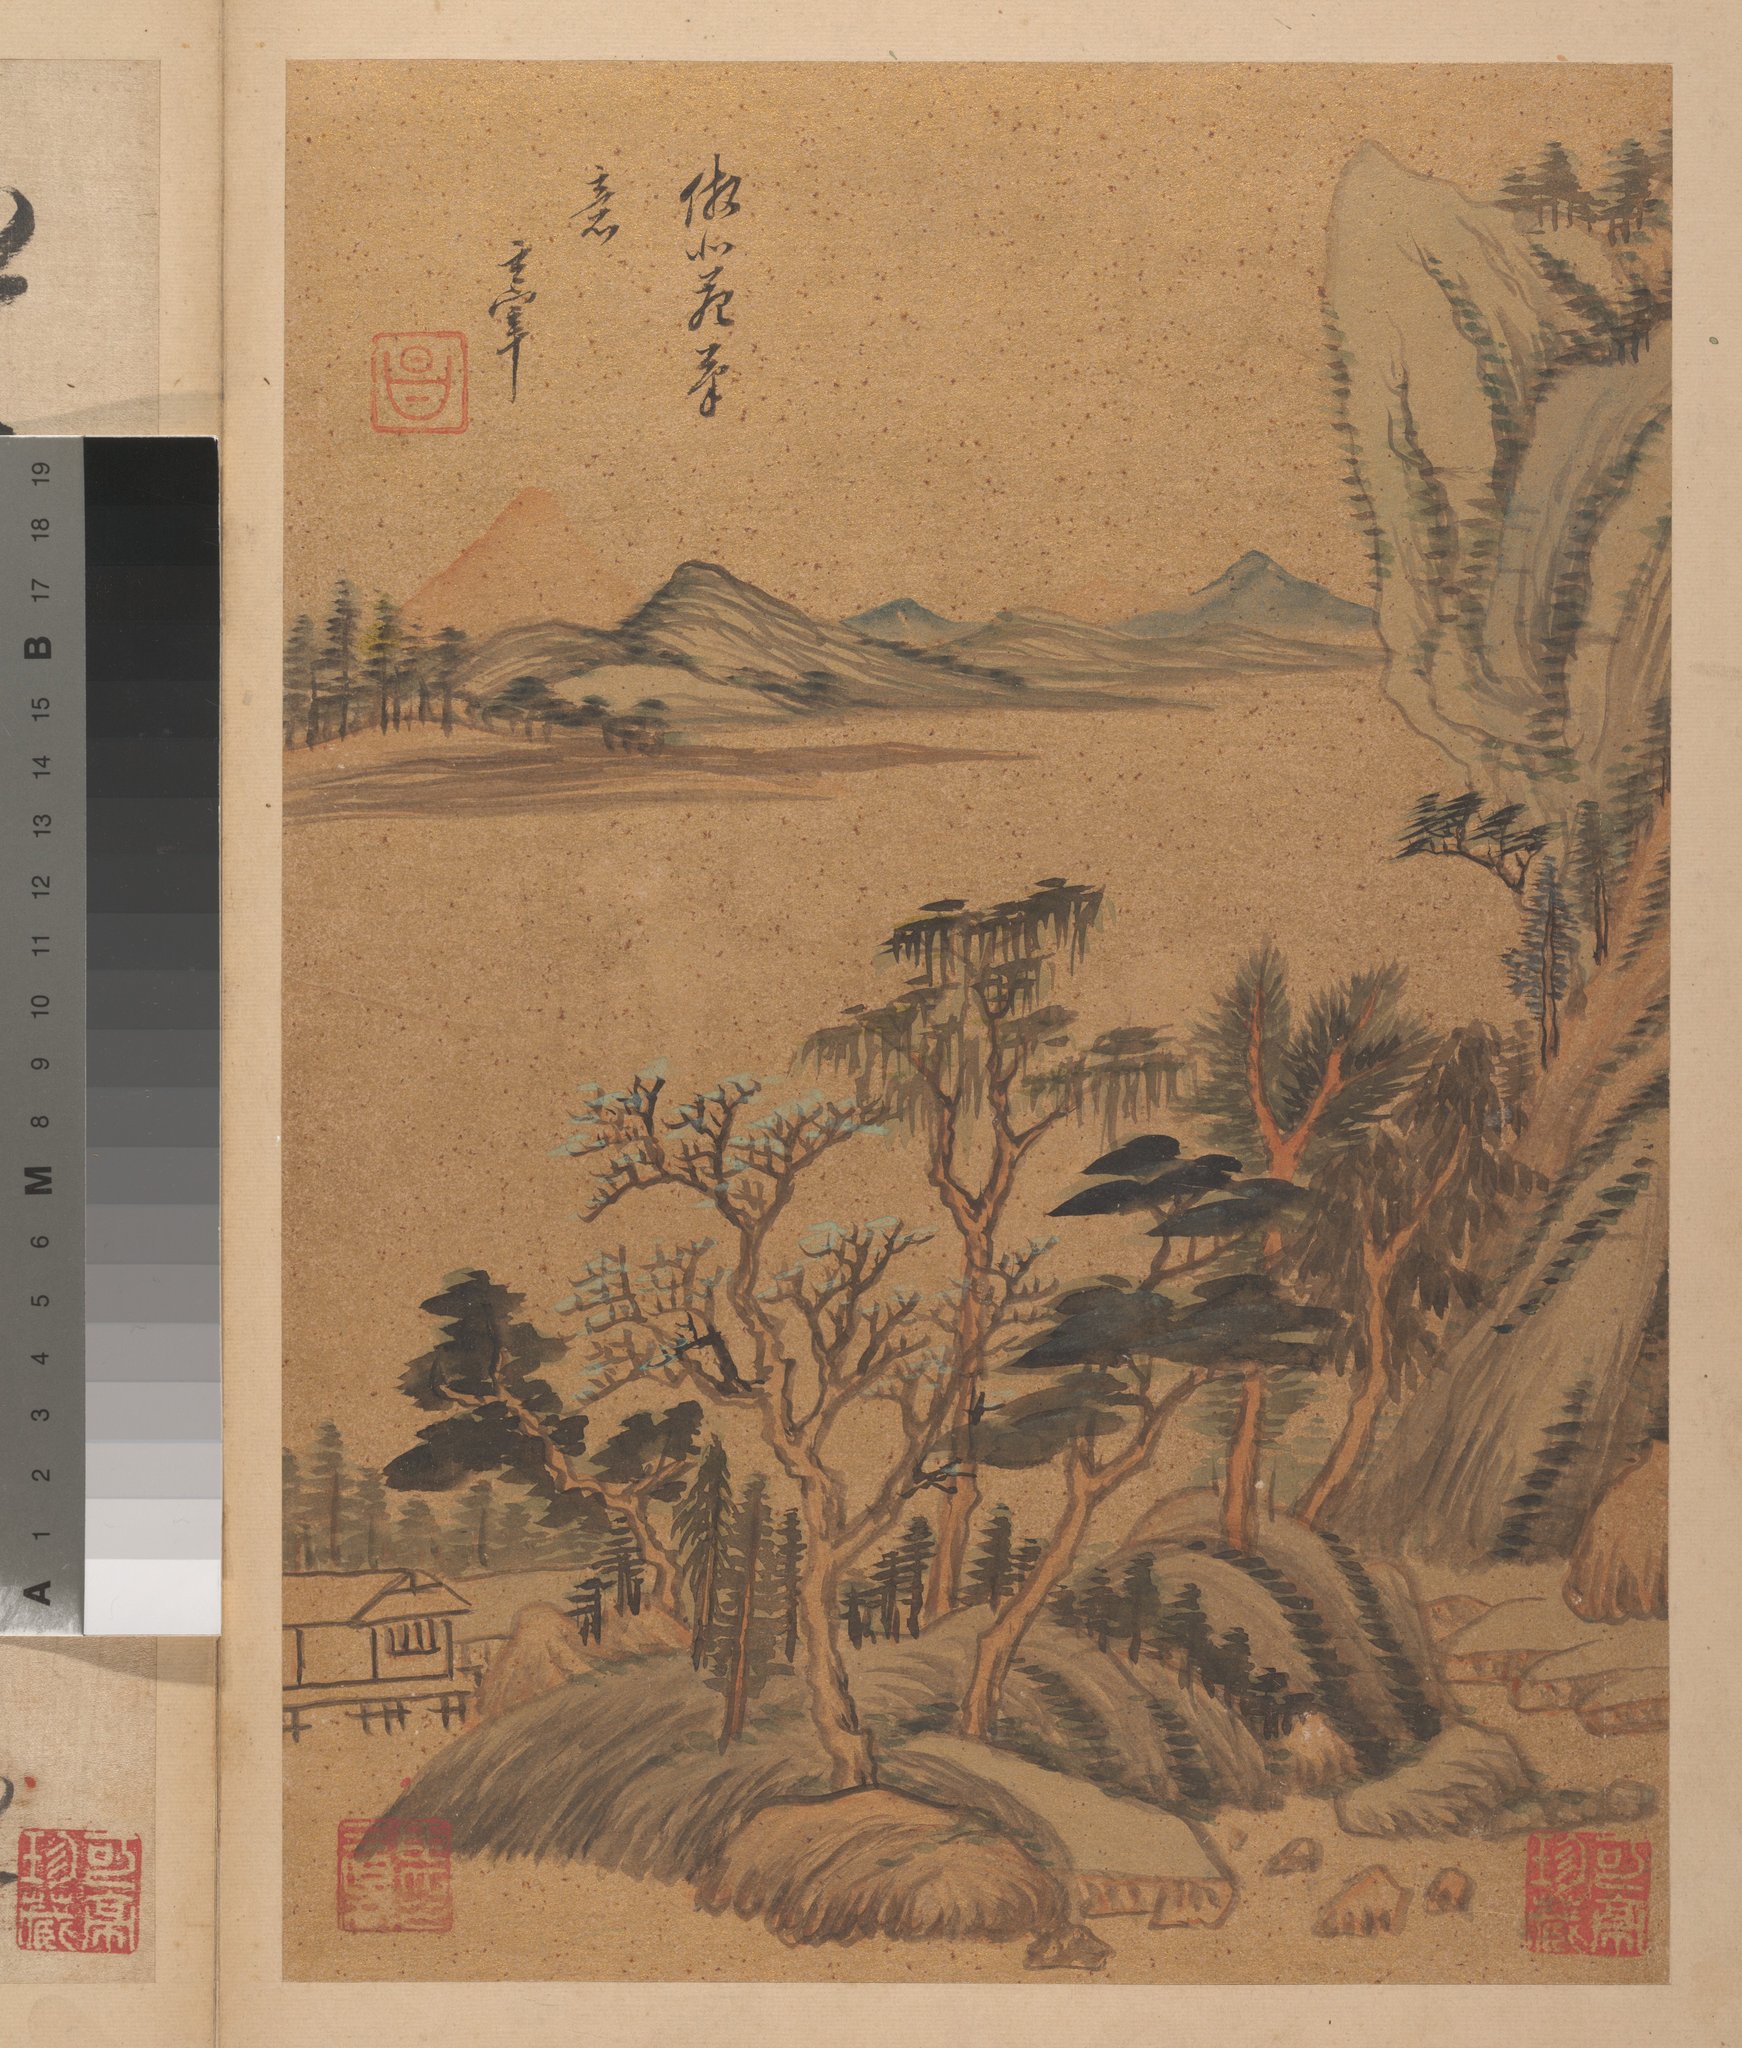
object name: album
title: Landscapes and poems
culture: chinese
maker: dong qichang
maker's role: artist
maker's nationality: chinese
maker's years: 1555-1636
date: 1601-1633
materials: gold, ink, paper, textile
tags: mountains,landscapes